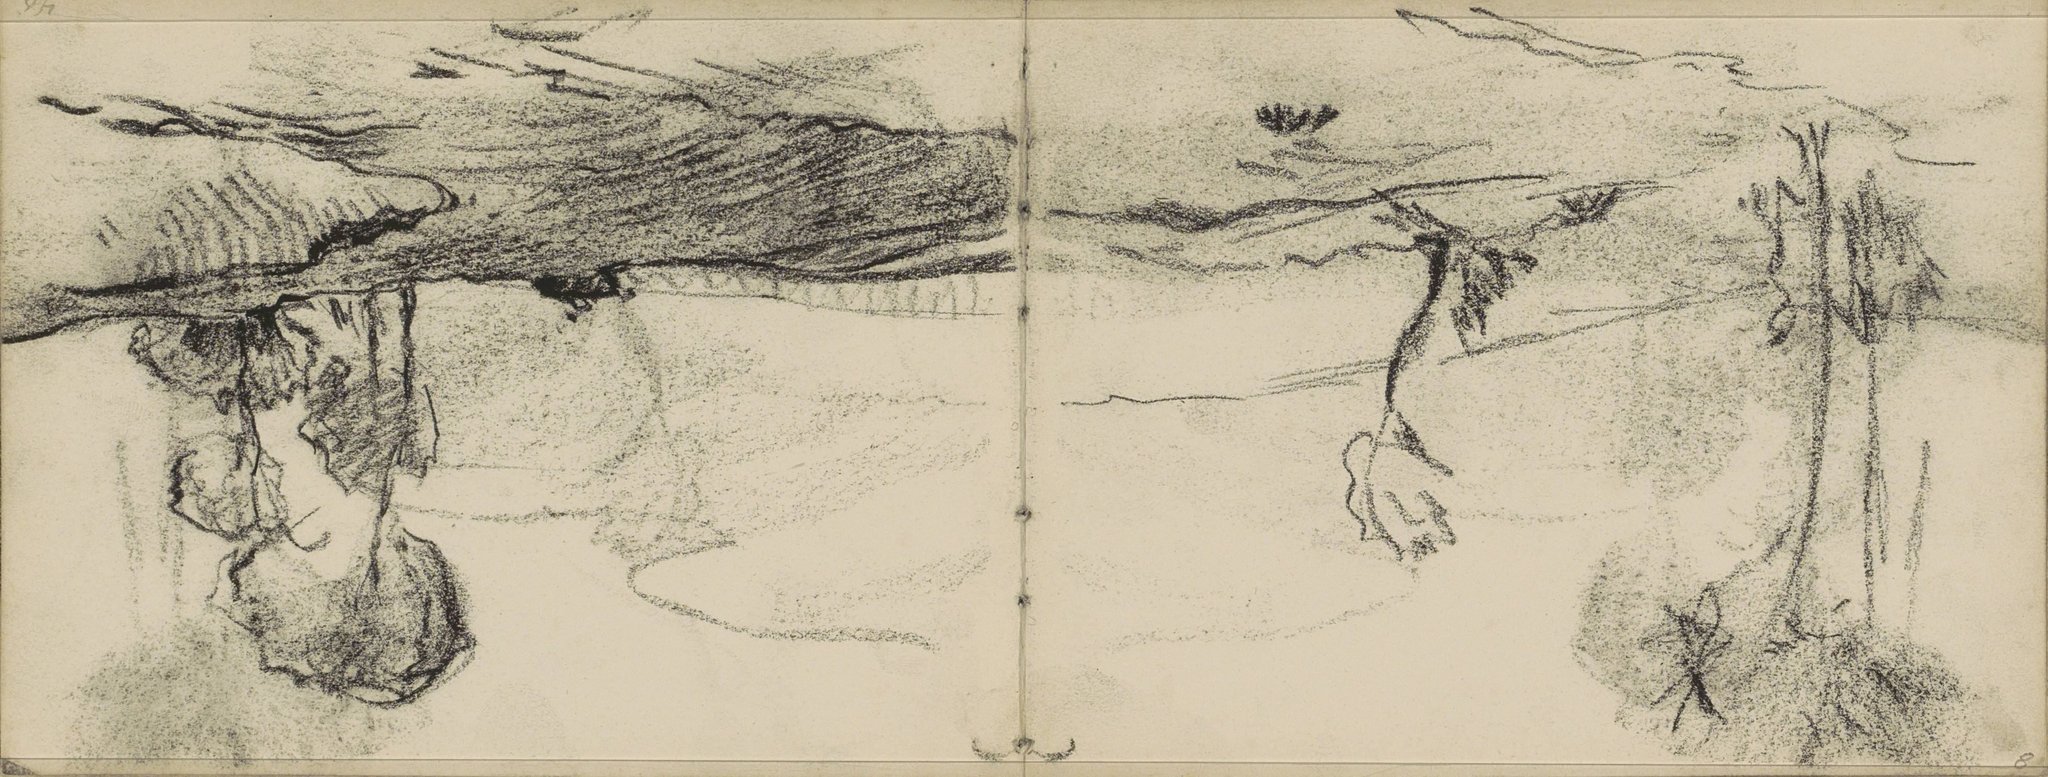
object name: sketchbook leaf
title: Landschap met bomen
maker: hermannus adrianus van oosterzee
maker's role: draughtsman, painter, print maker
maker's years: 1863-1933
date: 1893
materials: charcoal, paper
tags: trees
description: Blad 7 verso en 8 recto uit een schetsboek met 23 bladen.